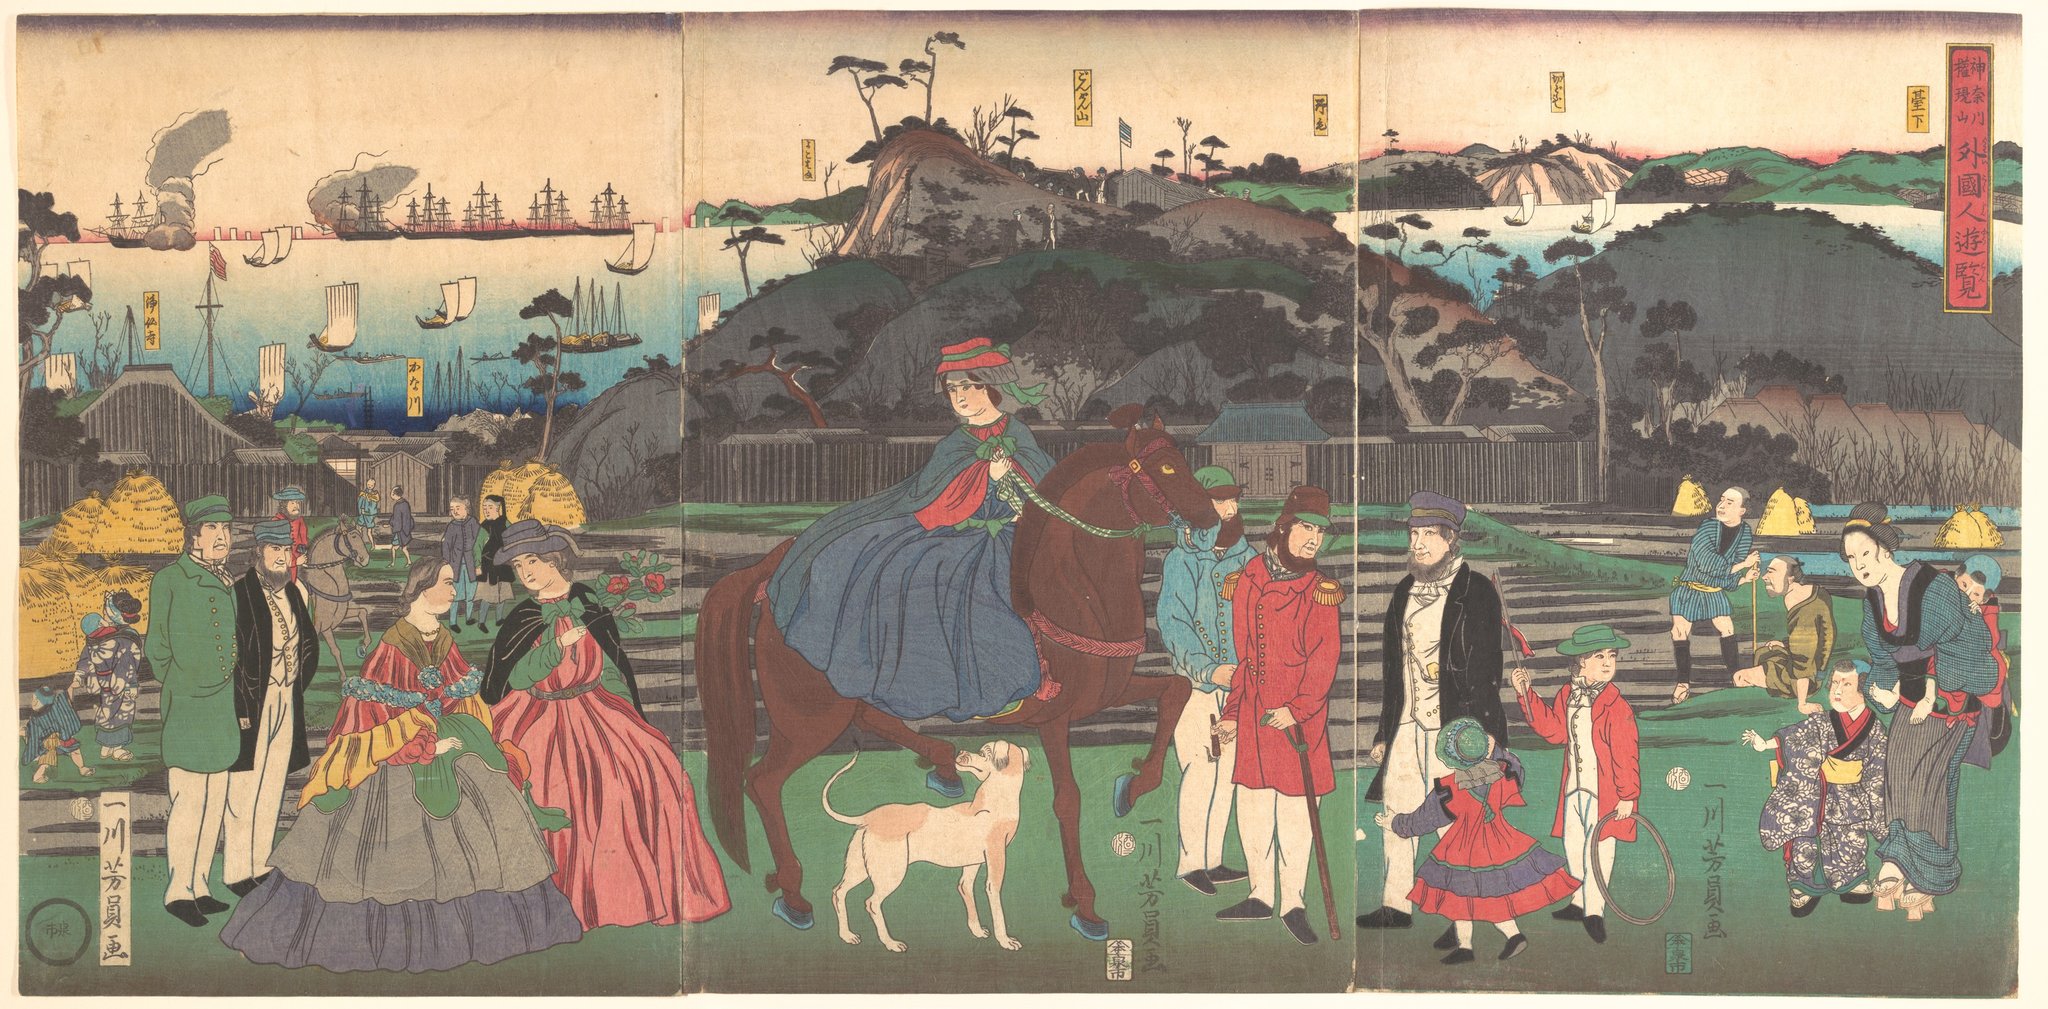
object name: print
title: Foreigners Visiting the Famous Site of Mt. Gongen in Kanagawa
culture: japanese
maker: utagawa yoshikazu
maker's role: artist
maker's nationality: japanese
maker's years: 1845-1870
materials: ink, paper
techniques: woodblock print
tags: men,women,horses,mountains,landscapes